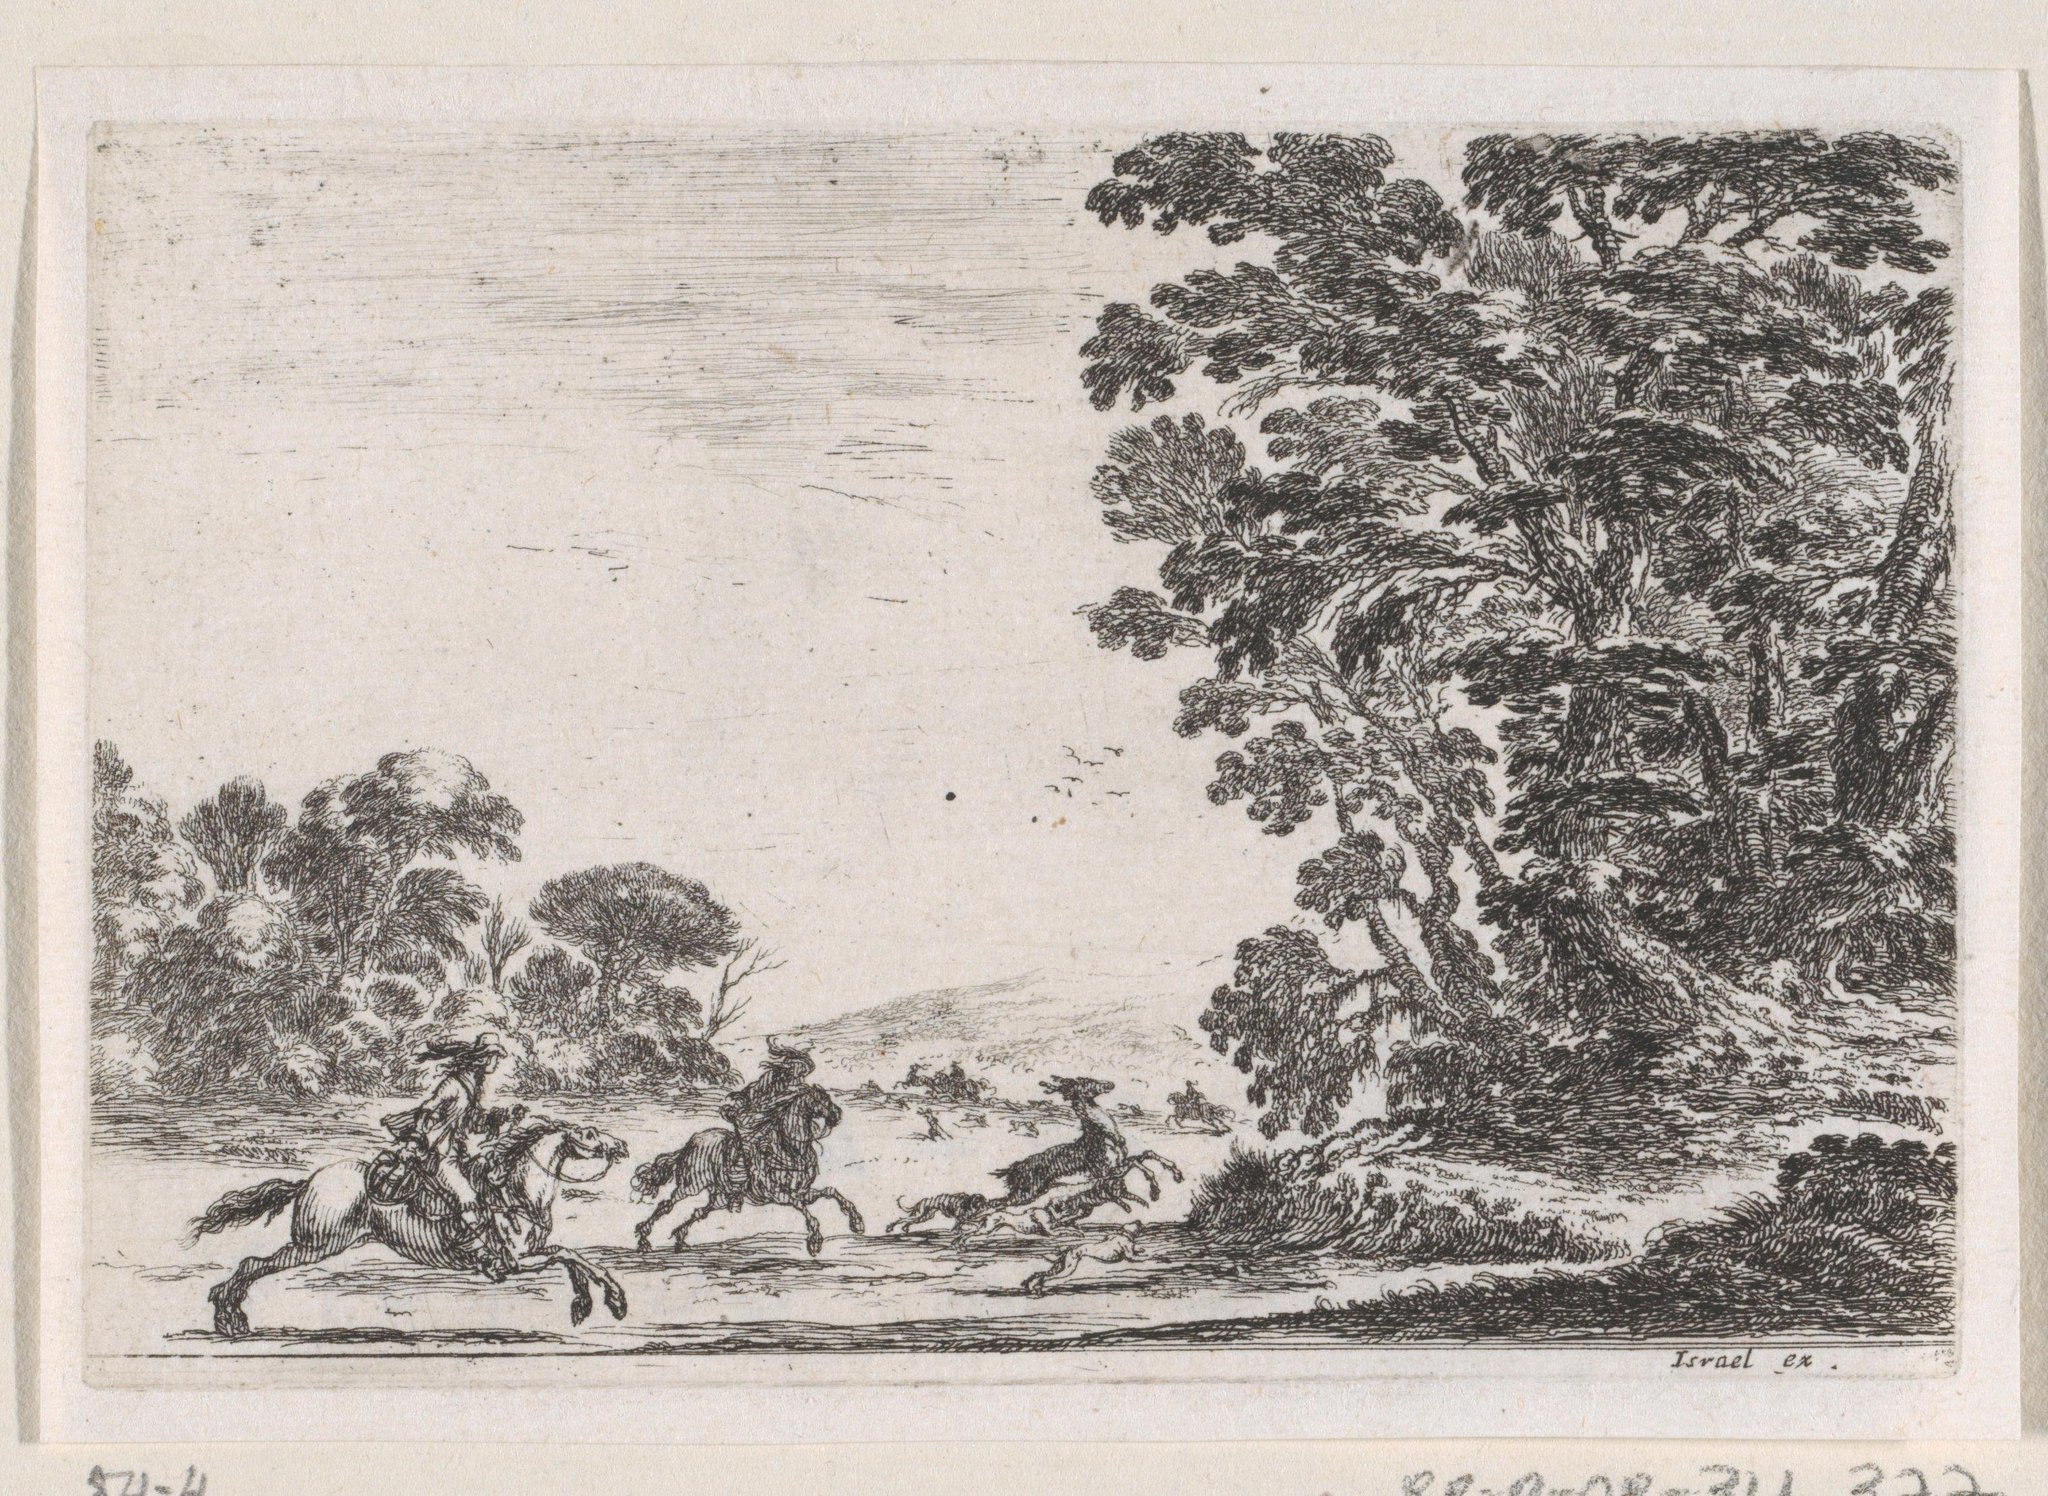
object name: print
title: Twee jagers te paard op hertenjacht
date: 1642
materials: paper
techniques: etching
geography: paris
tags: stag-hunting, hunter, hunters hunting (n.b.: in 1988-1990 this notation denoted the concept of 43c11421 'hunters resting during the hunt')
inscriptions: collector's mark: Lugt 240